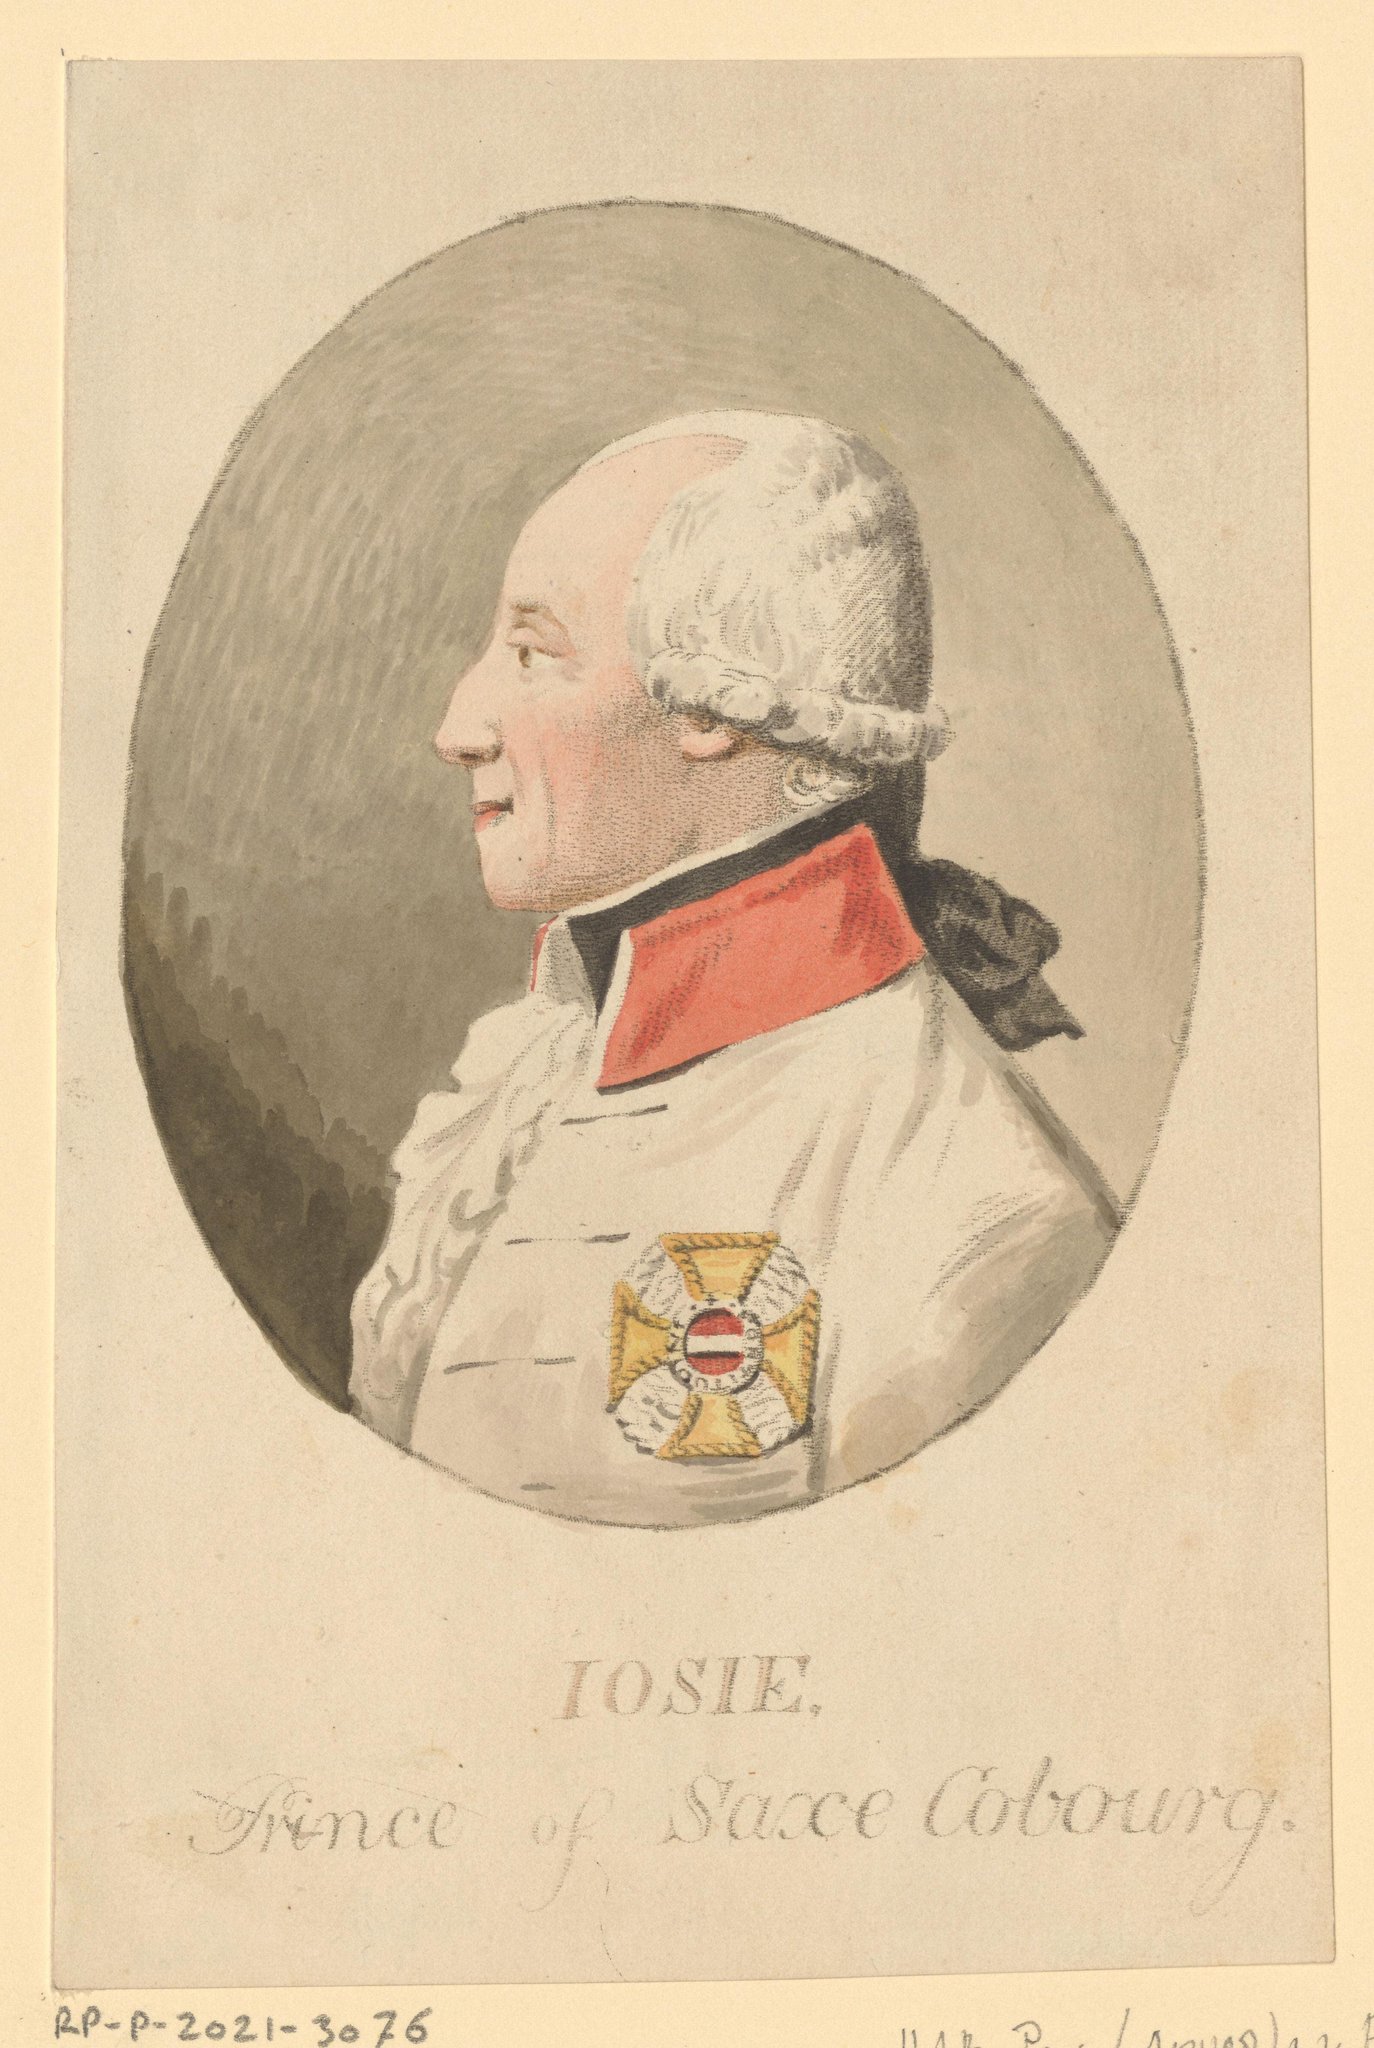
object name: print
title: Portret van Frederik Jozias Saksen-Coburg-Saalfeld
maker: Anonymous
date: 1750-1849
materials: paper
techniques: etching, hand coloring, rocker stamped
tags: knighthood order, commander-in-chief, general, marshal, prince, historical persons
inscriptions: inscription: ‘bl. 523.’, inscription: ‘Hertogdom Saxen-Coburg-/ Gotha.’, inscription